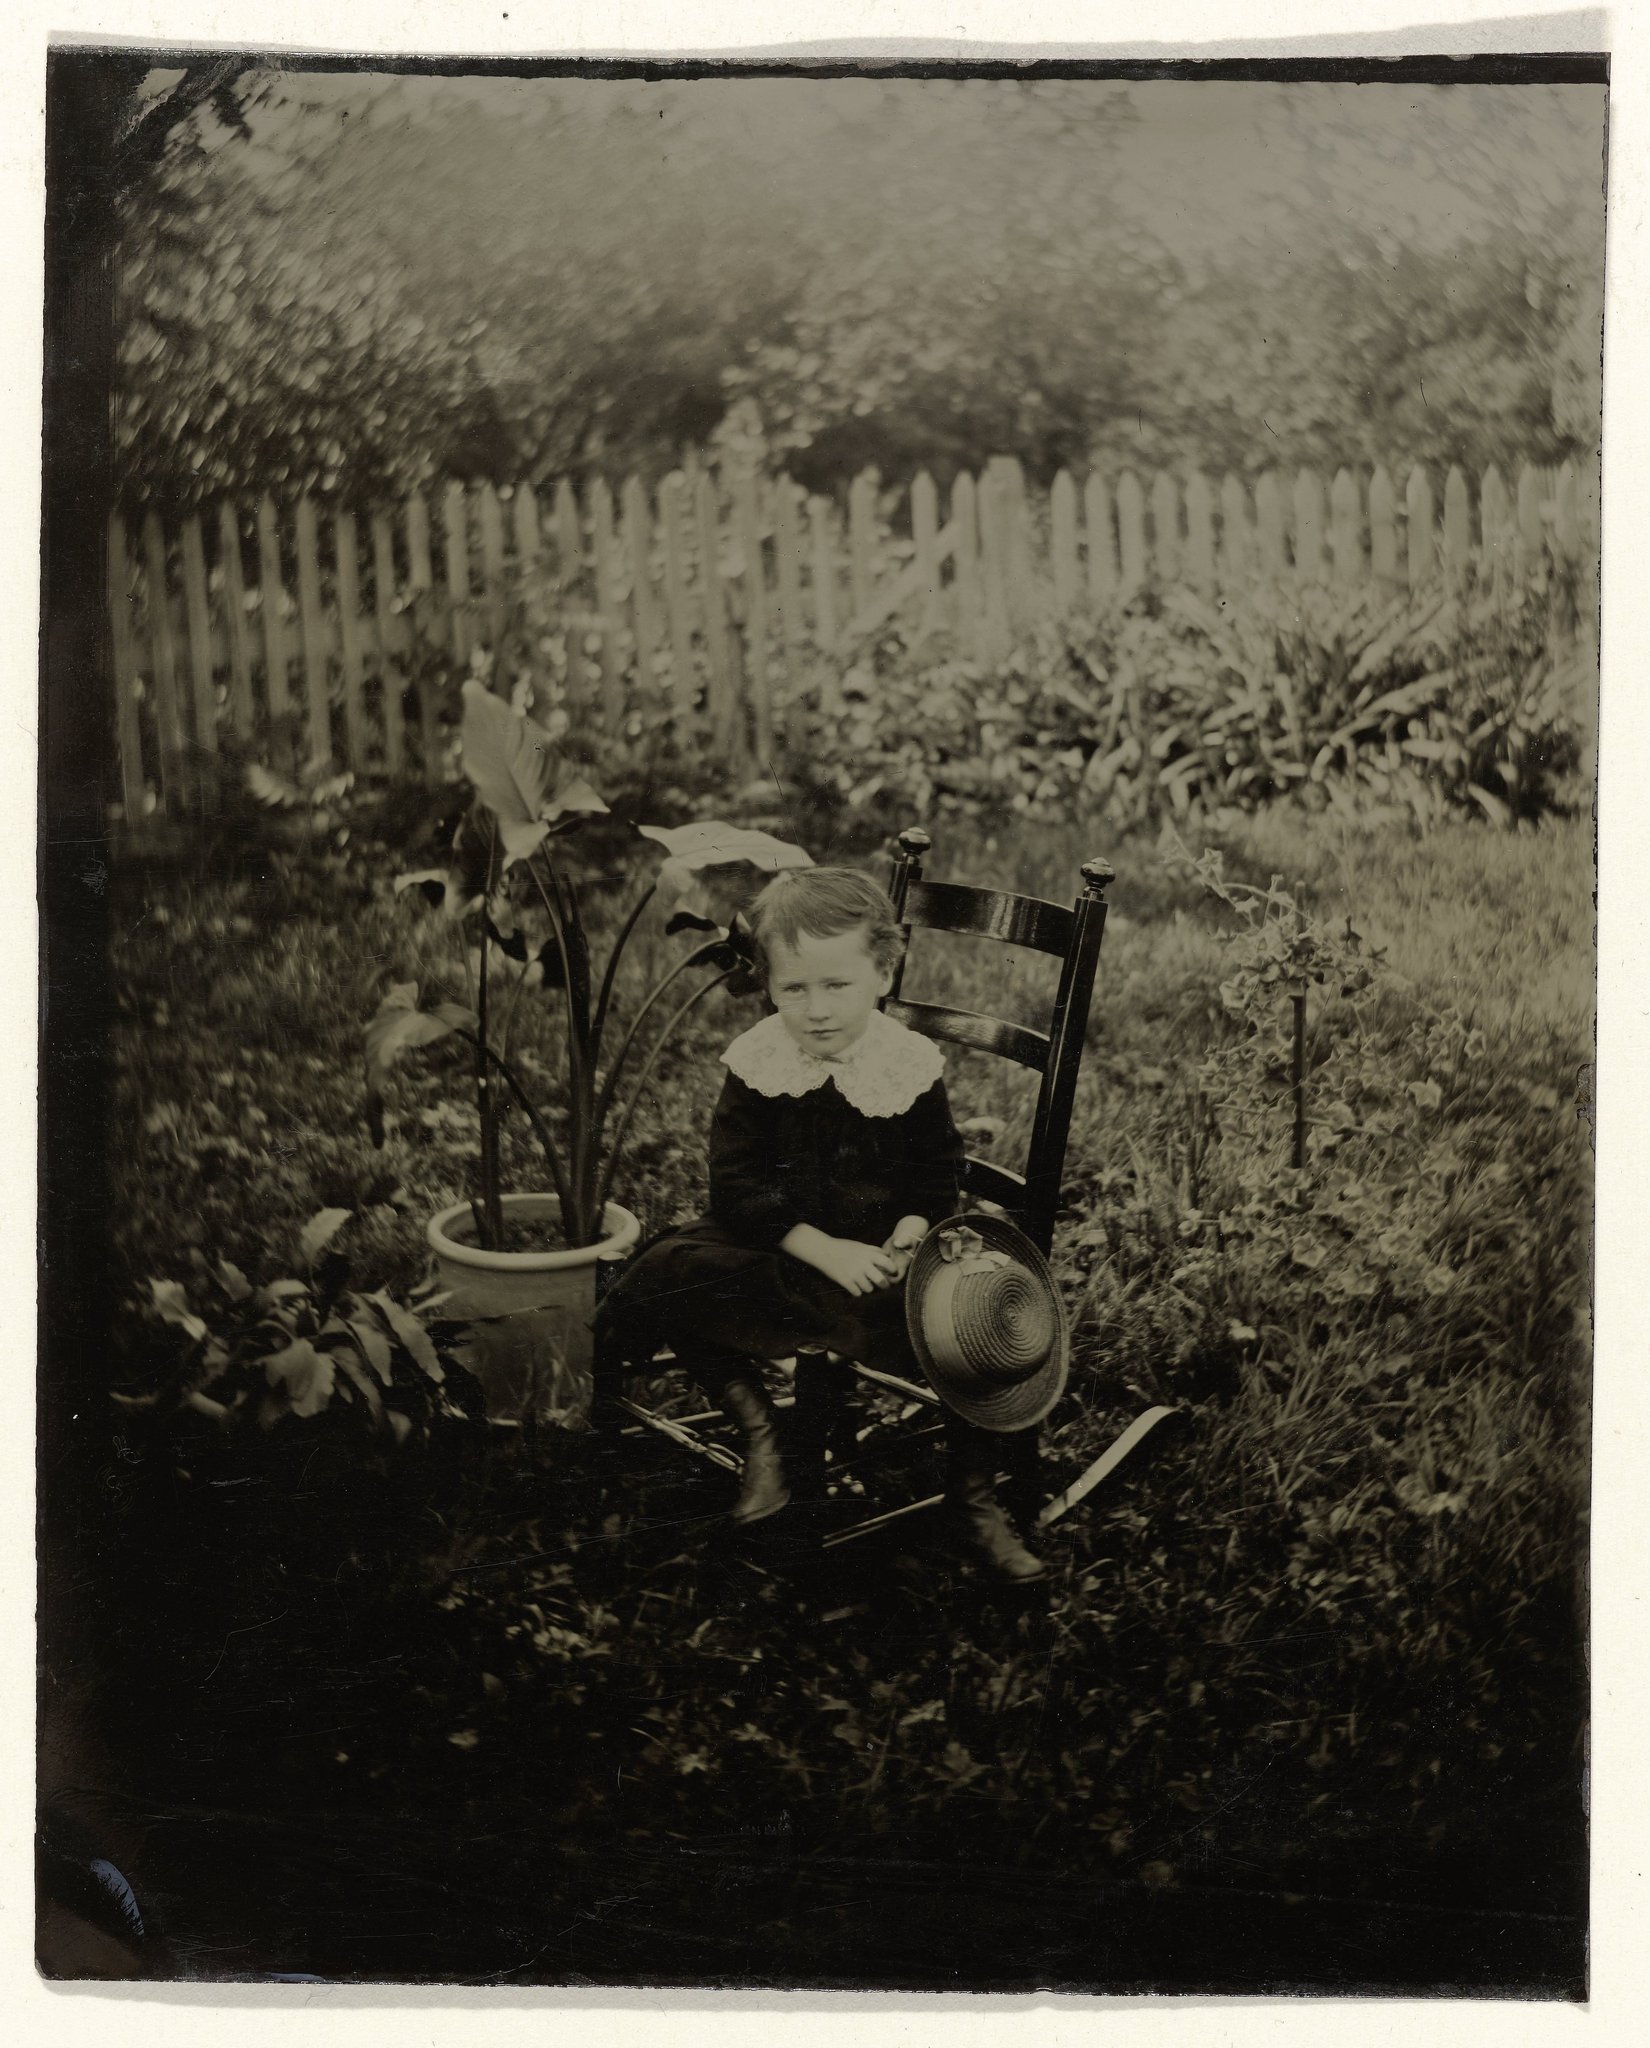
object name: photograph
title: Portret van een jongen, zittend op een stoel in een tuin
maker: Anonymous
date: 1860-1900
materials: metal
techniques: ferrotyping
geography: north and central america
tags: boy (child between toddler and youth), historical persons not known by name